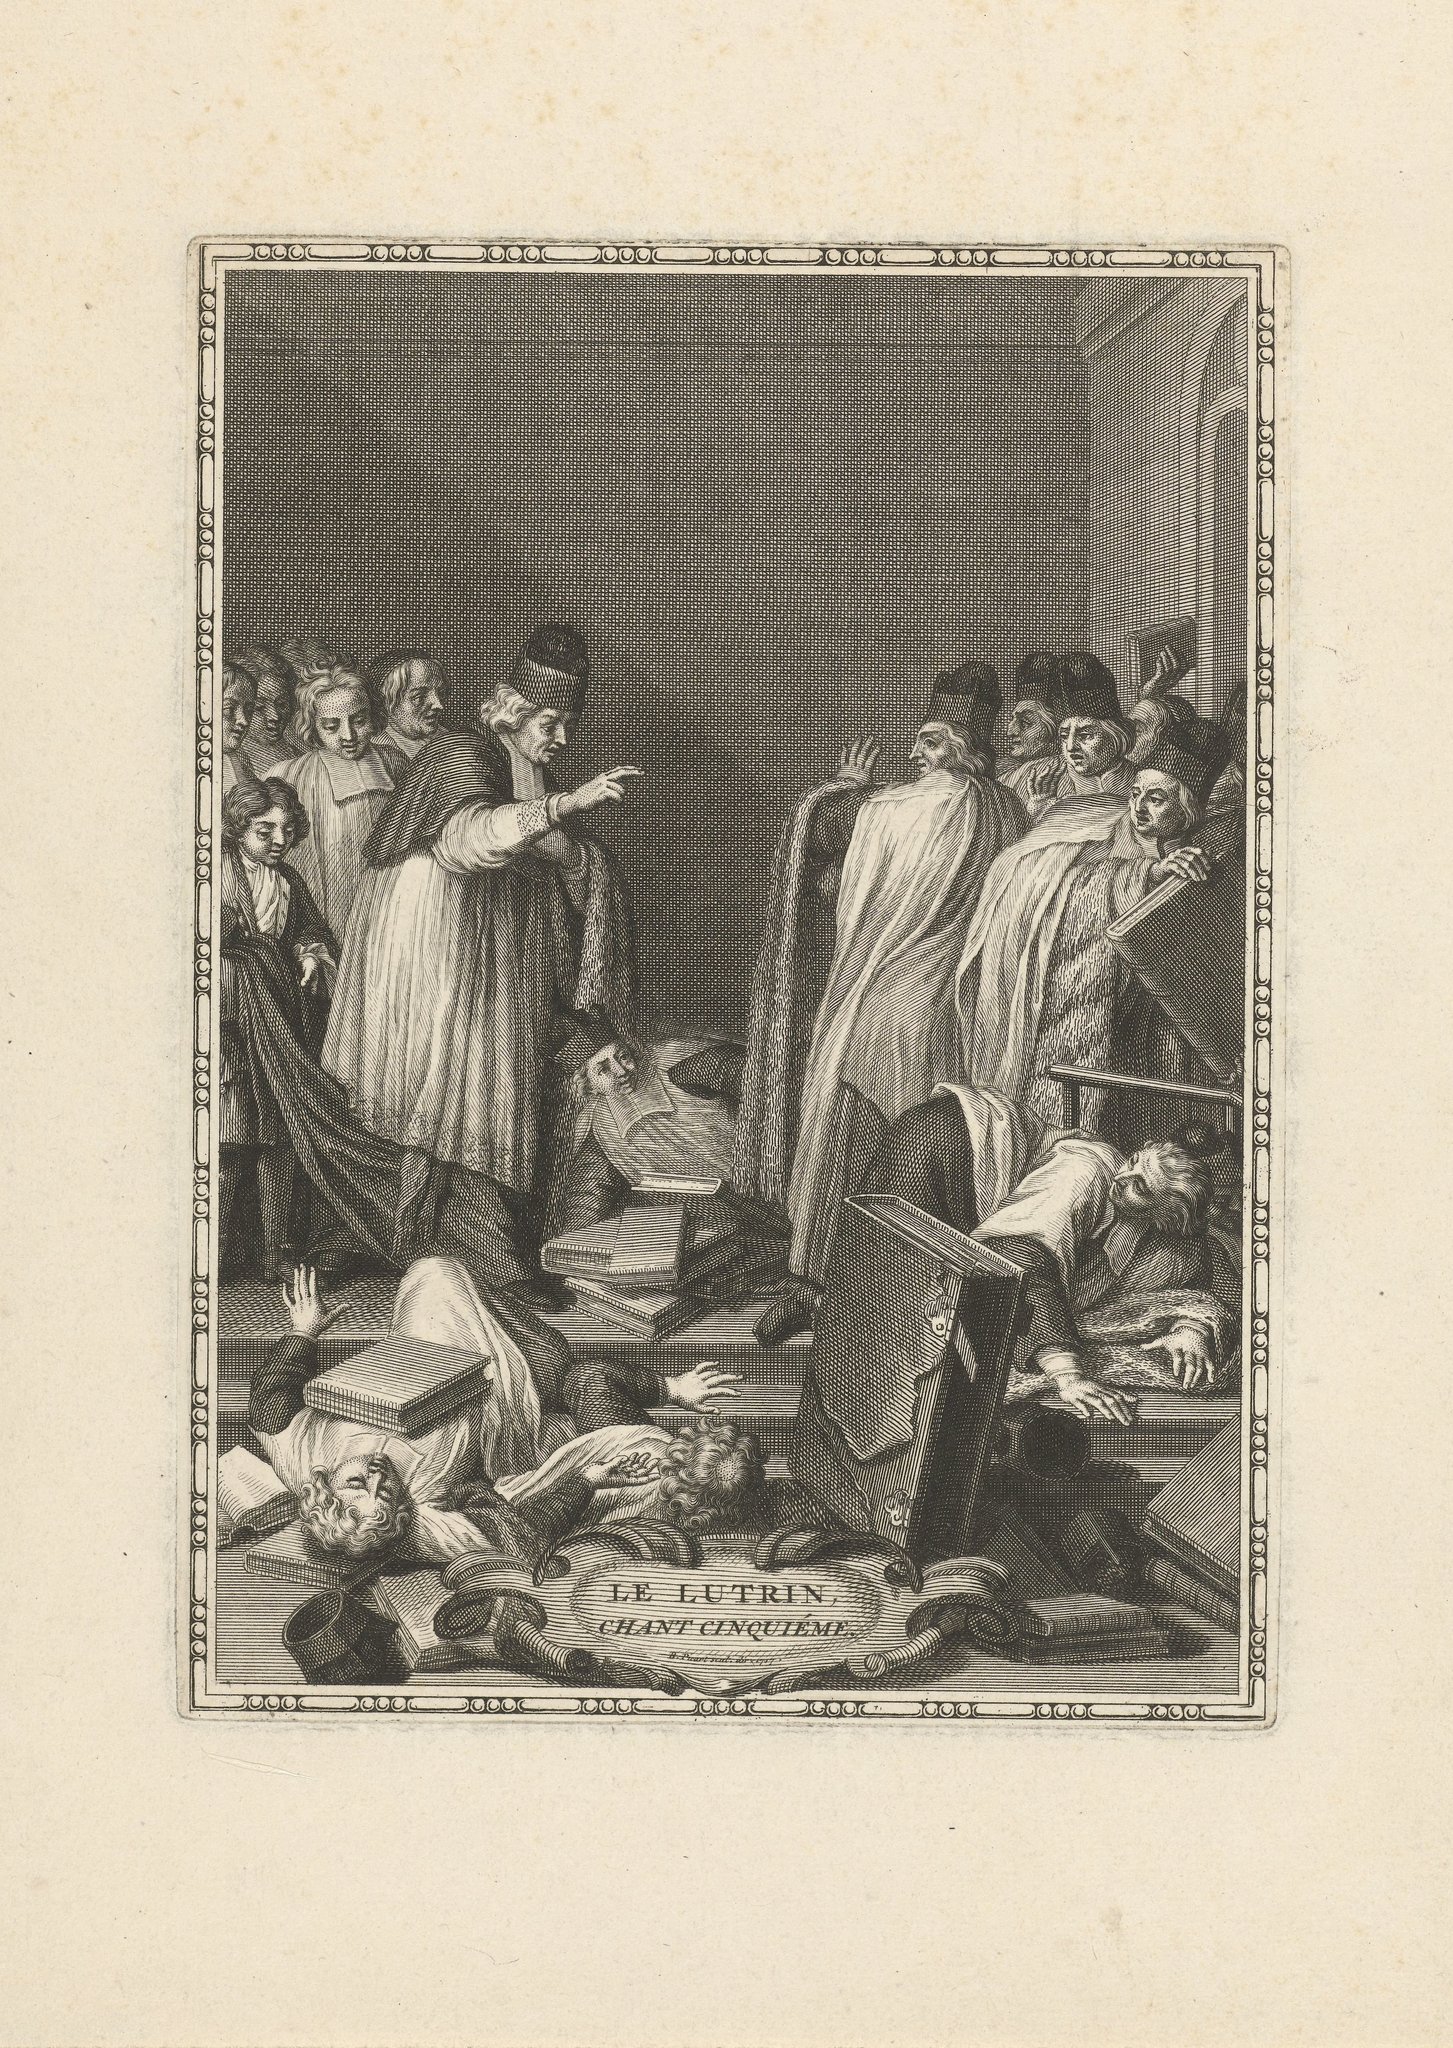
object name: book illustration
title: Le Lutrin. Chant Cinquiéme.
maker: bernard picart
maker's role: draughtsman, print maker, publisher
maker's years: 1673-1733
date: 1717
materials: paper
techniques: engraving, etching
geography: amsterdam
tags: book, falling, organization, functionaries and dignitaries in roman catholic church; clergy in general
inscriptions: collector's mark: Lugt 240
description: Prent ook gebruikt als illustratie in: Boileau, Nicolas. Oeuvres de Nicolas Boileau Despréaux. Deel I, voorafgaand aan p. 367. Amsterdam: David Mortier, 1718.